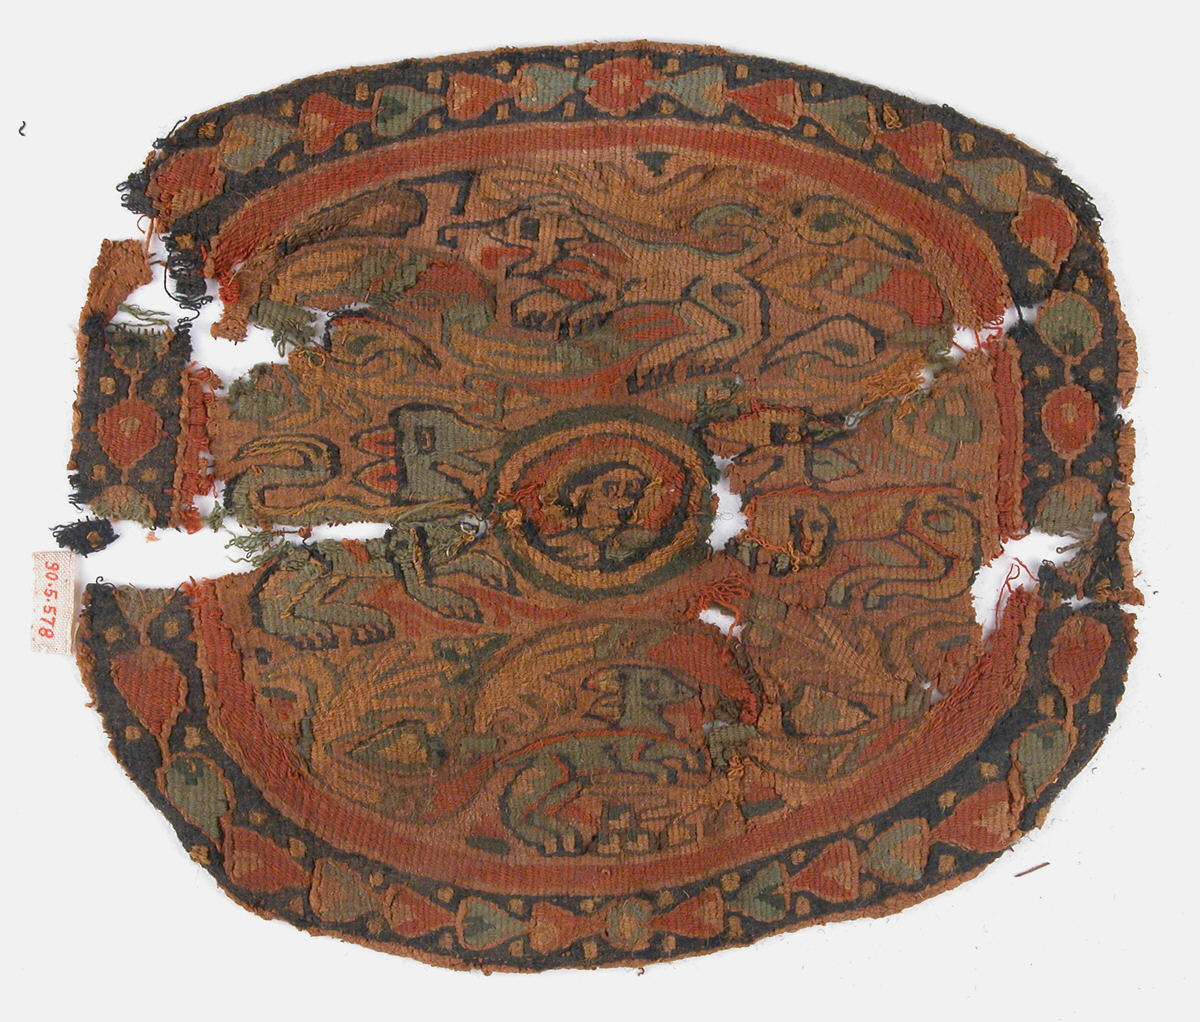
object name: textile fragment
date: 601-800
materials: linen, wool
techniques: weave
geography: egypt